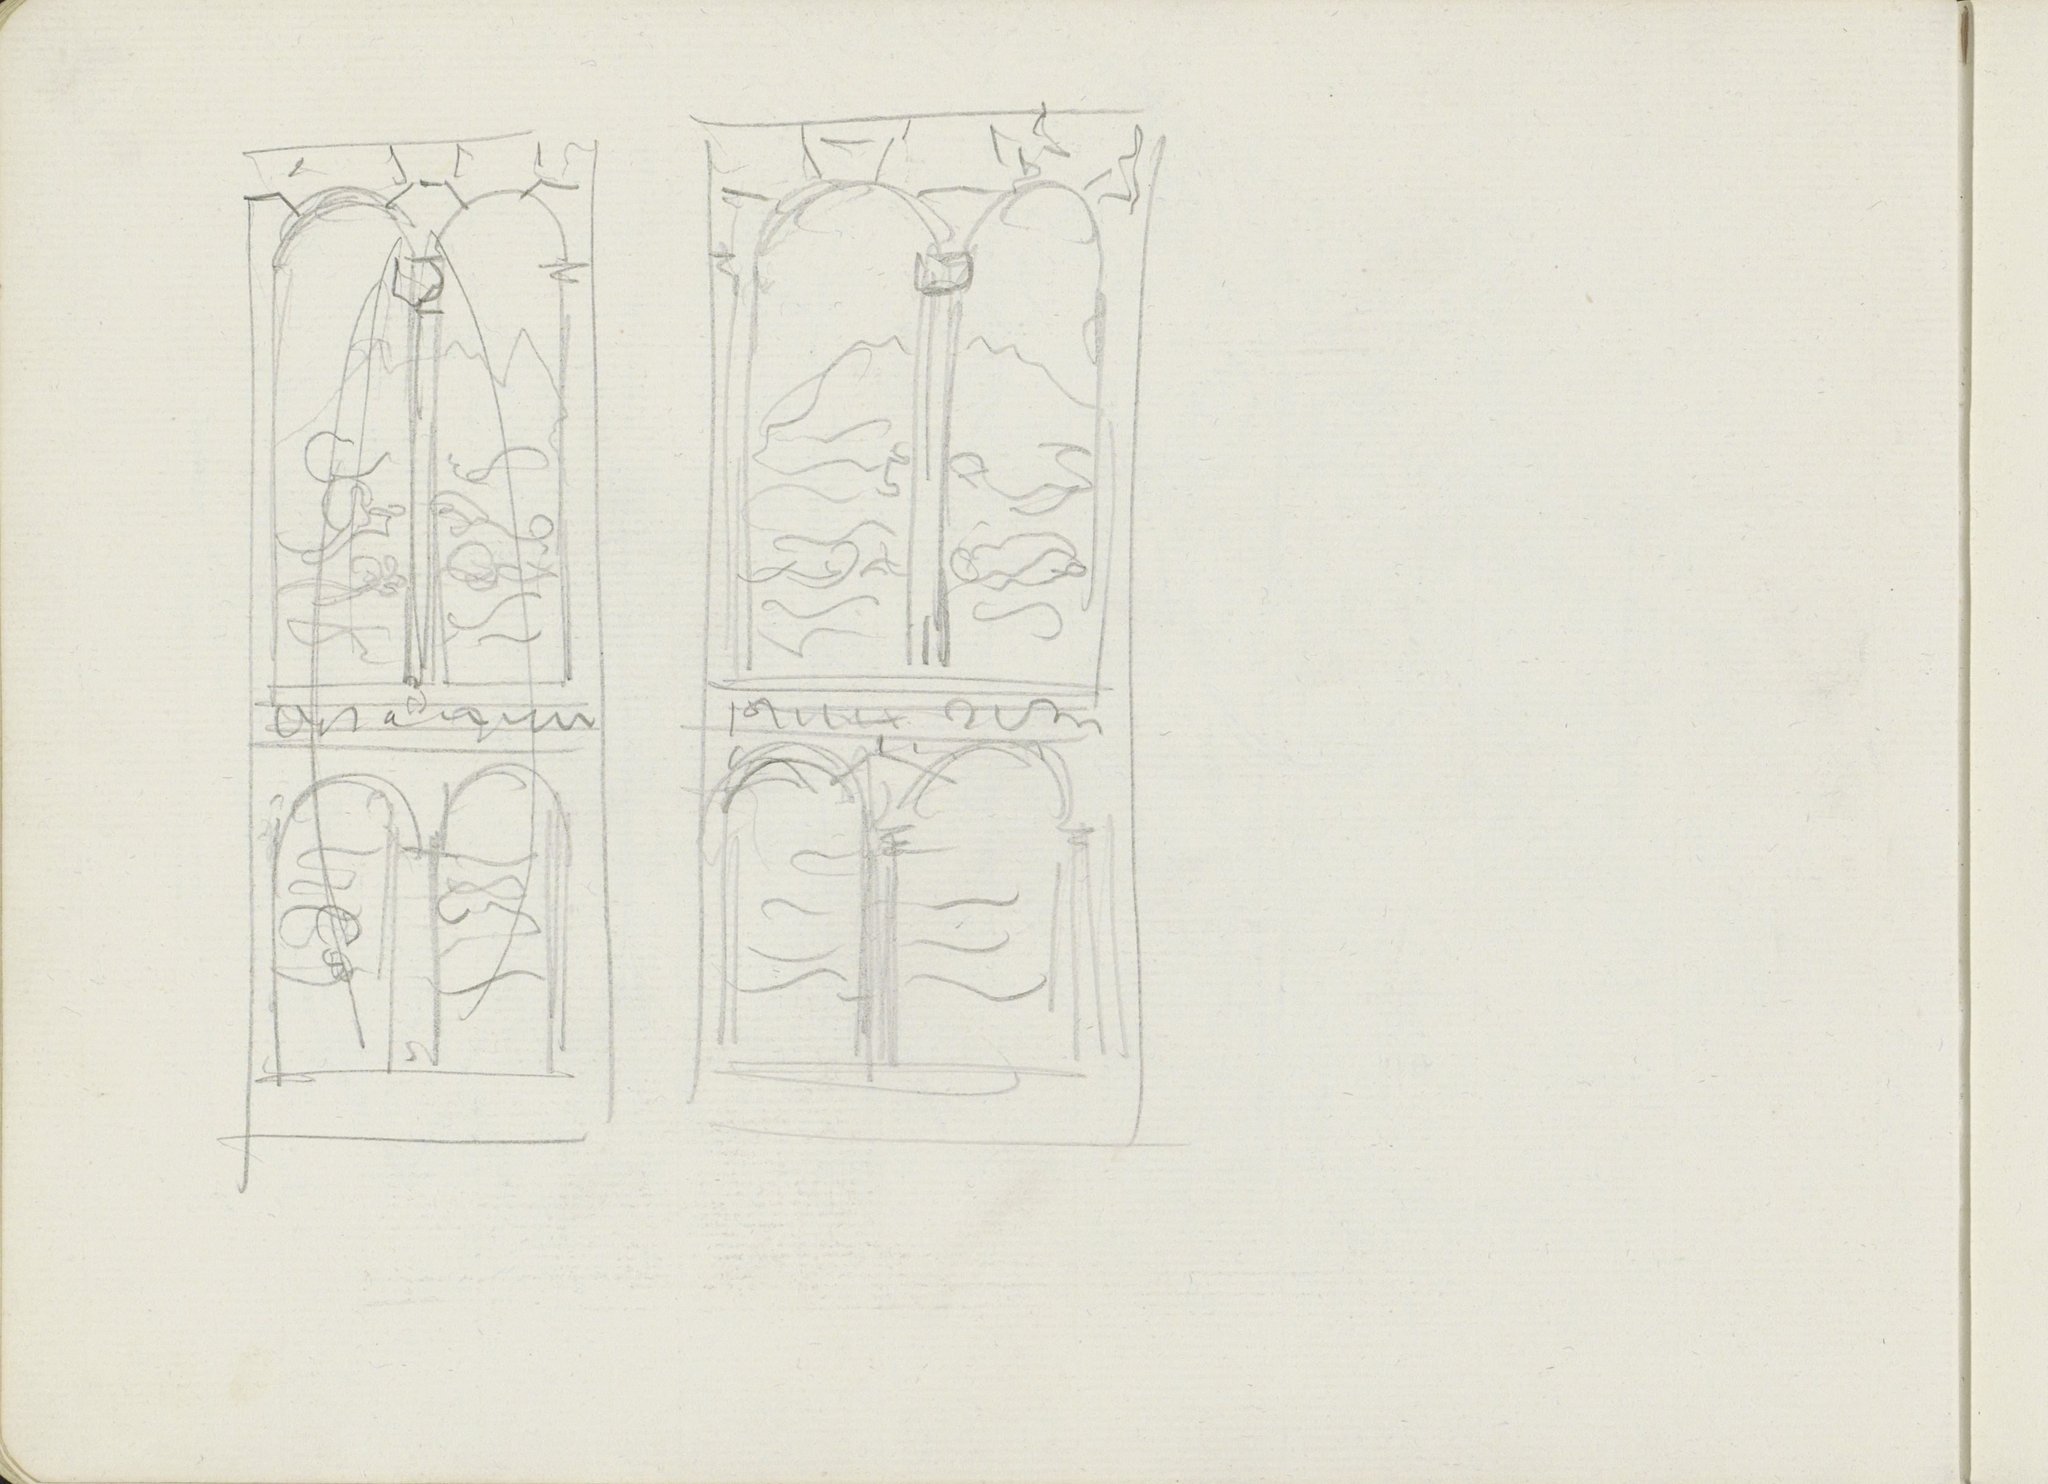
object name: sketchbook leaf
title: Ontwerpen voor wanddecoratie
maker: carel adolph lion cachet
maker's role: draughtsman, print maker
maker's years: 1864-1945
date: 1905-1910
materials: paper, pencil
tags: decorations (interior of the house)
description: Blad 19 verso uit een schetsboek met 27 bladen.